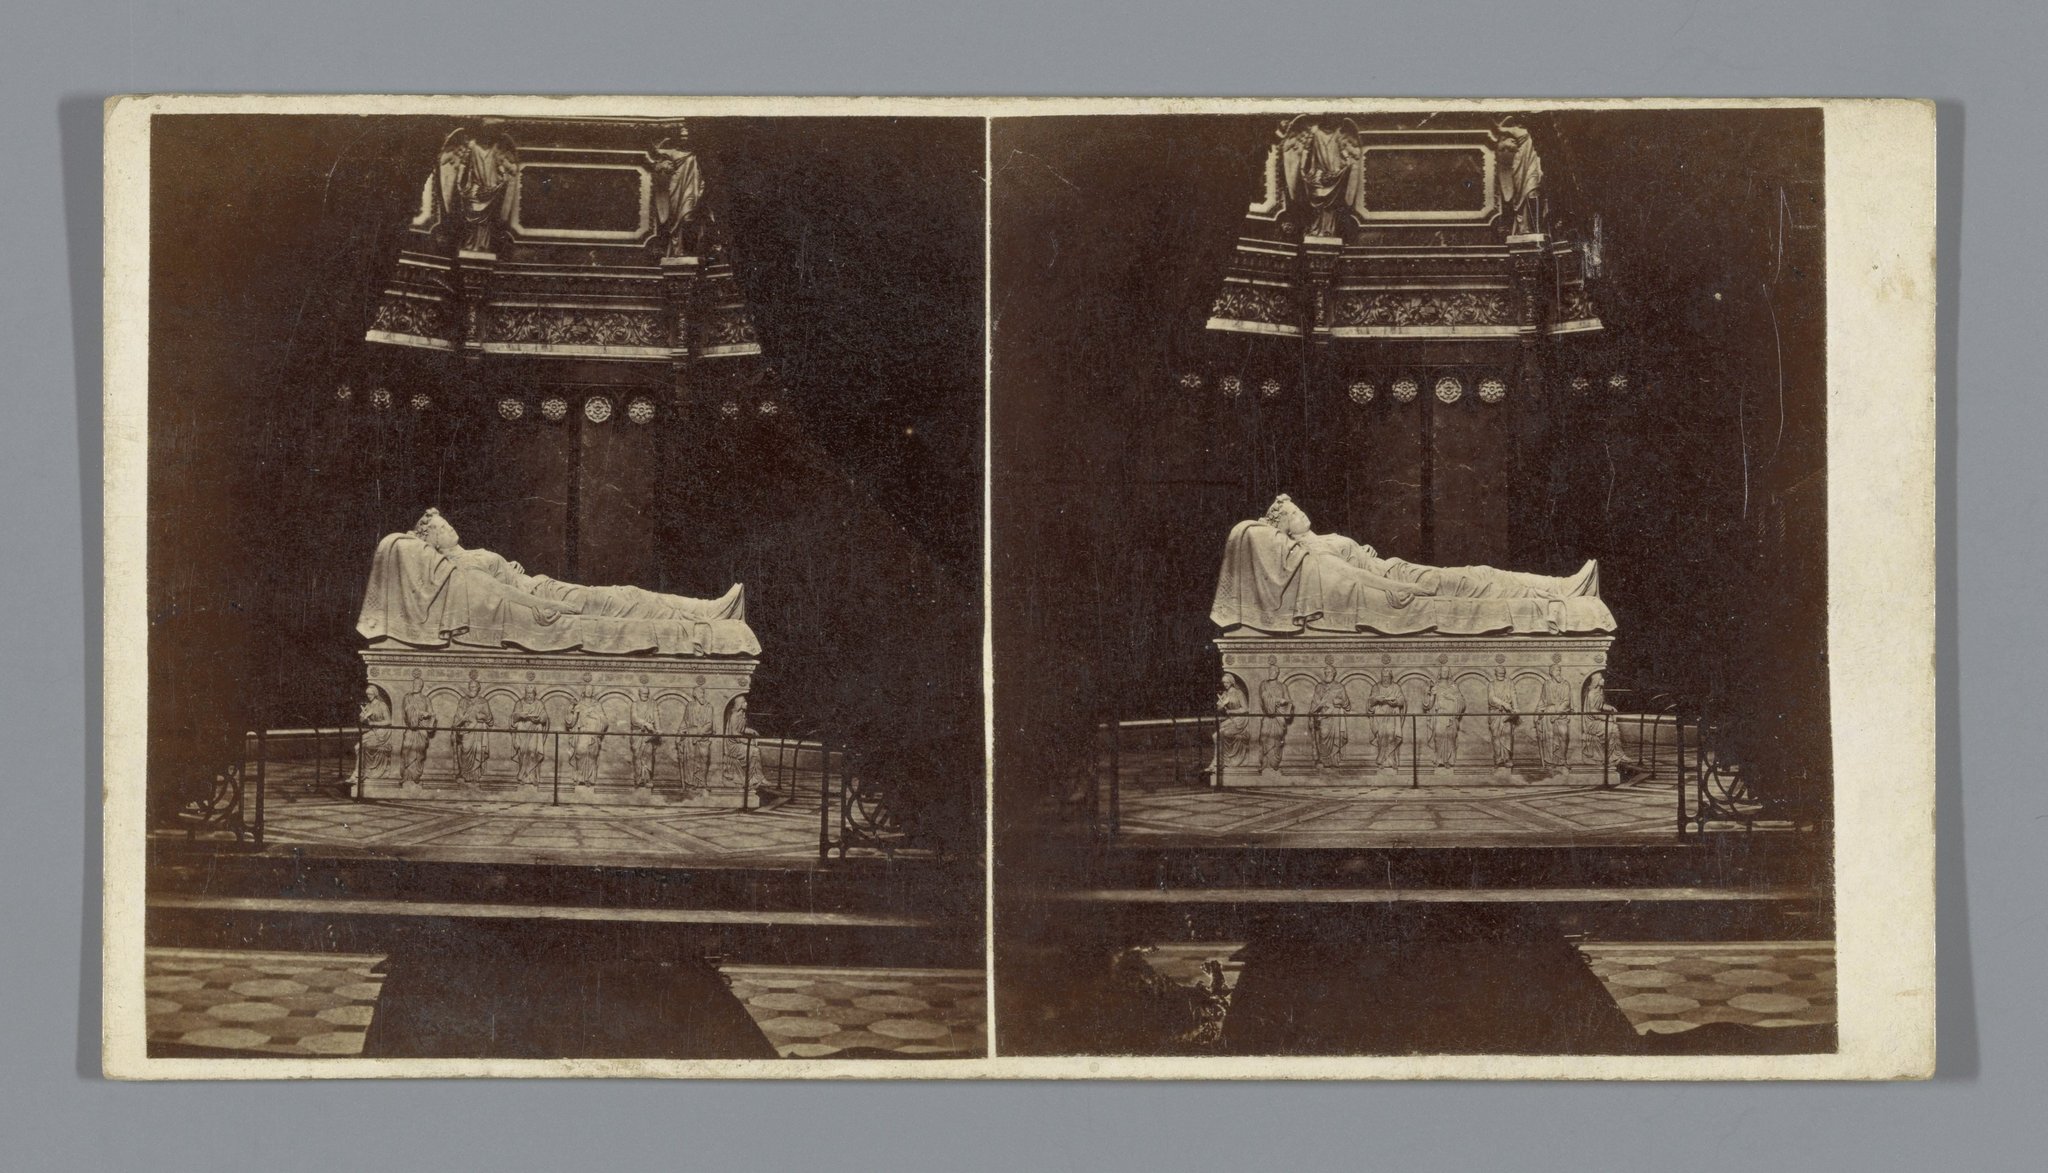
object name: stereograph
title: Graftombe van Elisabeth Michajlovna van Rusland in de Russische kerk van de Heilige Elisabeth te Wiesbaden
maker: l. wagner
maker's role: fotograaf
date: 1850-1900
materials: cardboard, photographic support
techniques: albumen print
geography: russische kerk van de heilige elisabeth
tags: grave, tomb, interior of church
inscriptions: inscription: ‘L. Wagner vorm. Wagner & Jäckel Hof-Photographen. Wiesbaden. Taunus-Str. 12’, inscription: ‘Wiesbaden’